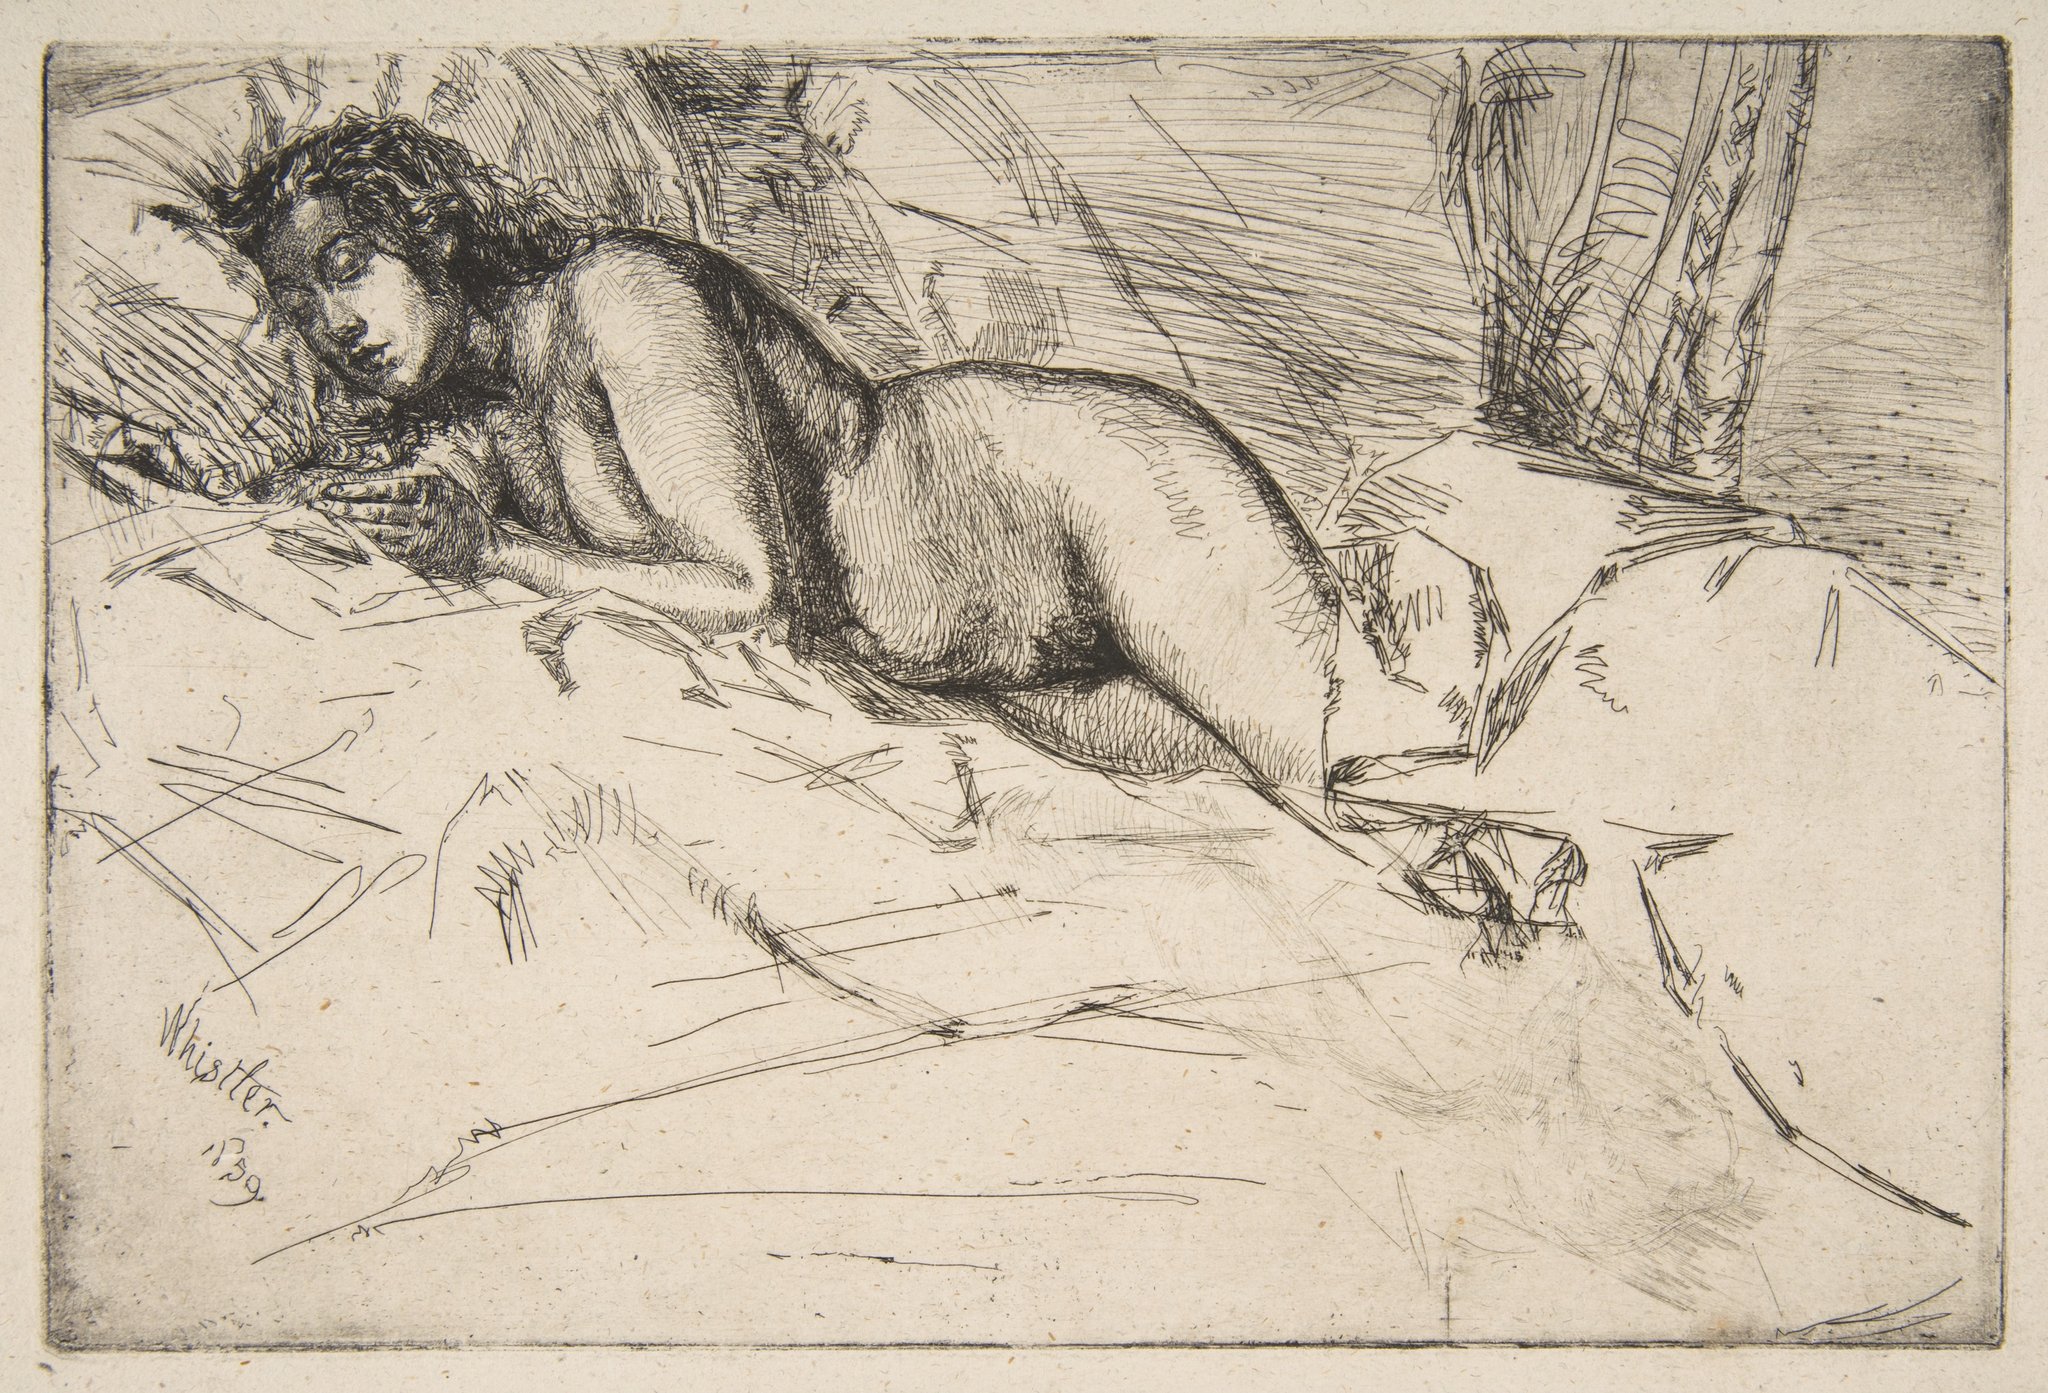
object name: print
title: Venus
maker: james mcneill whistler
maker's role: artist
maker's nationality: american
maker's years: 1834-1903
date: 1859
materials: ink, paper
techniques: drypoint, etching, printing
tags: sleeping,venus